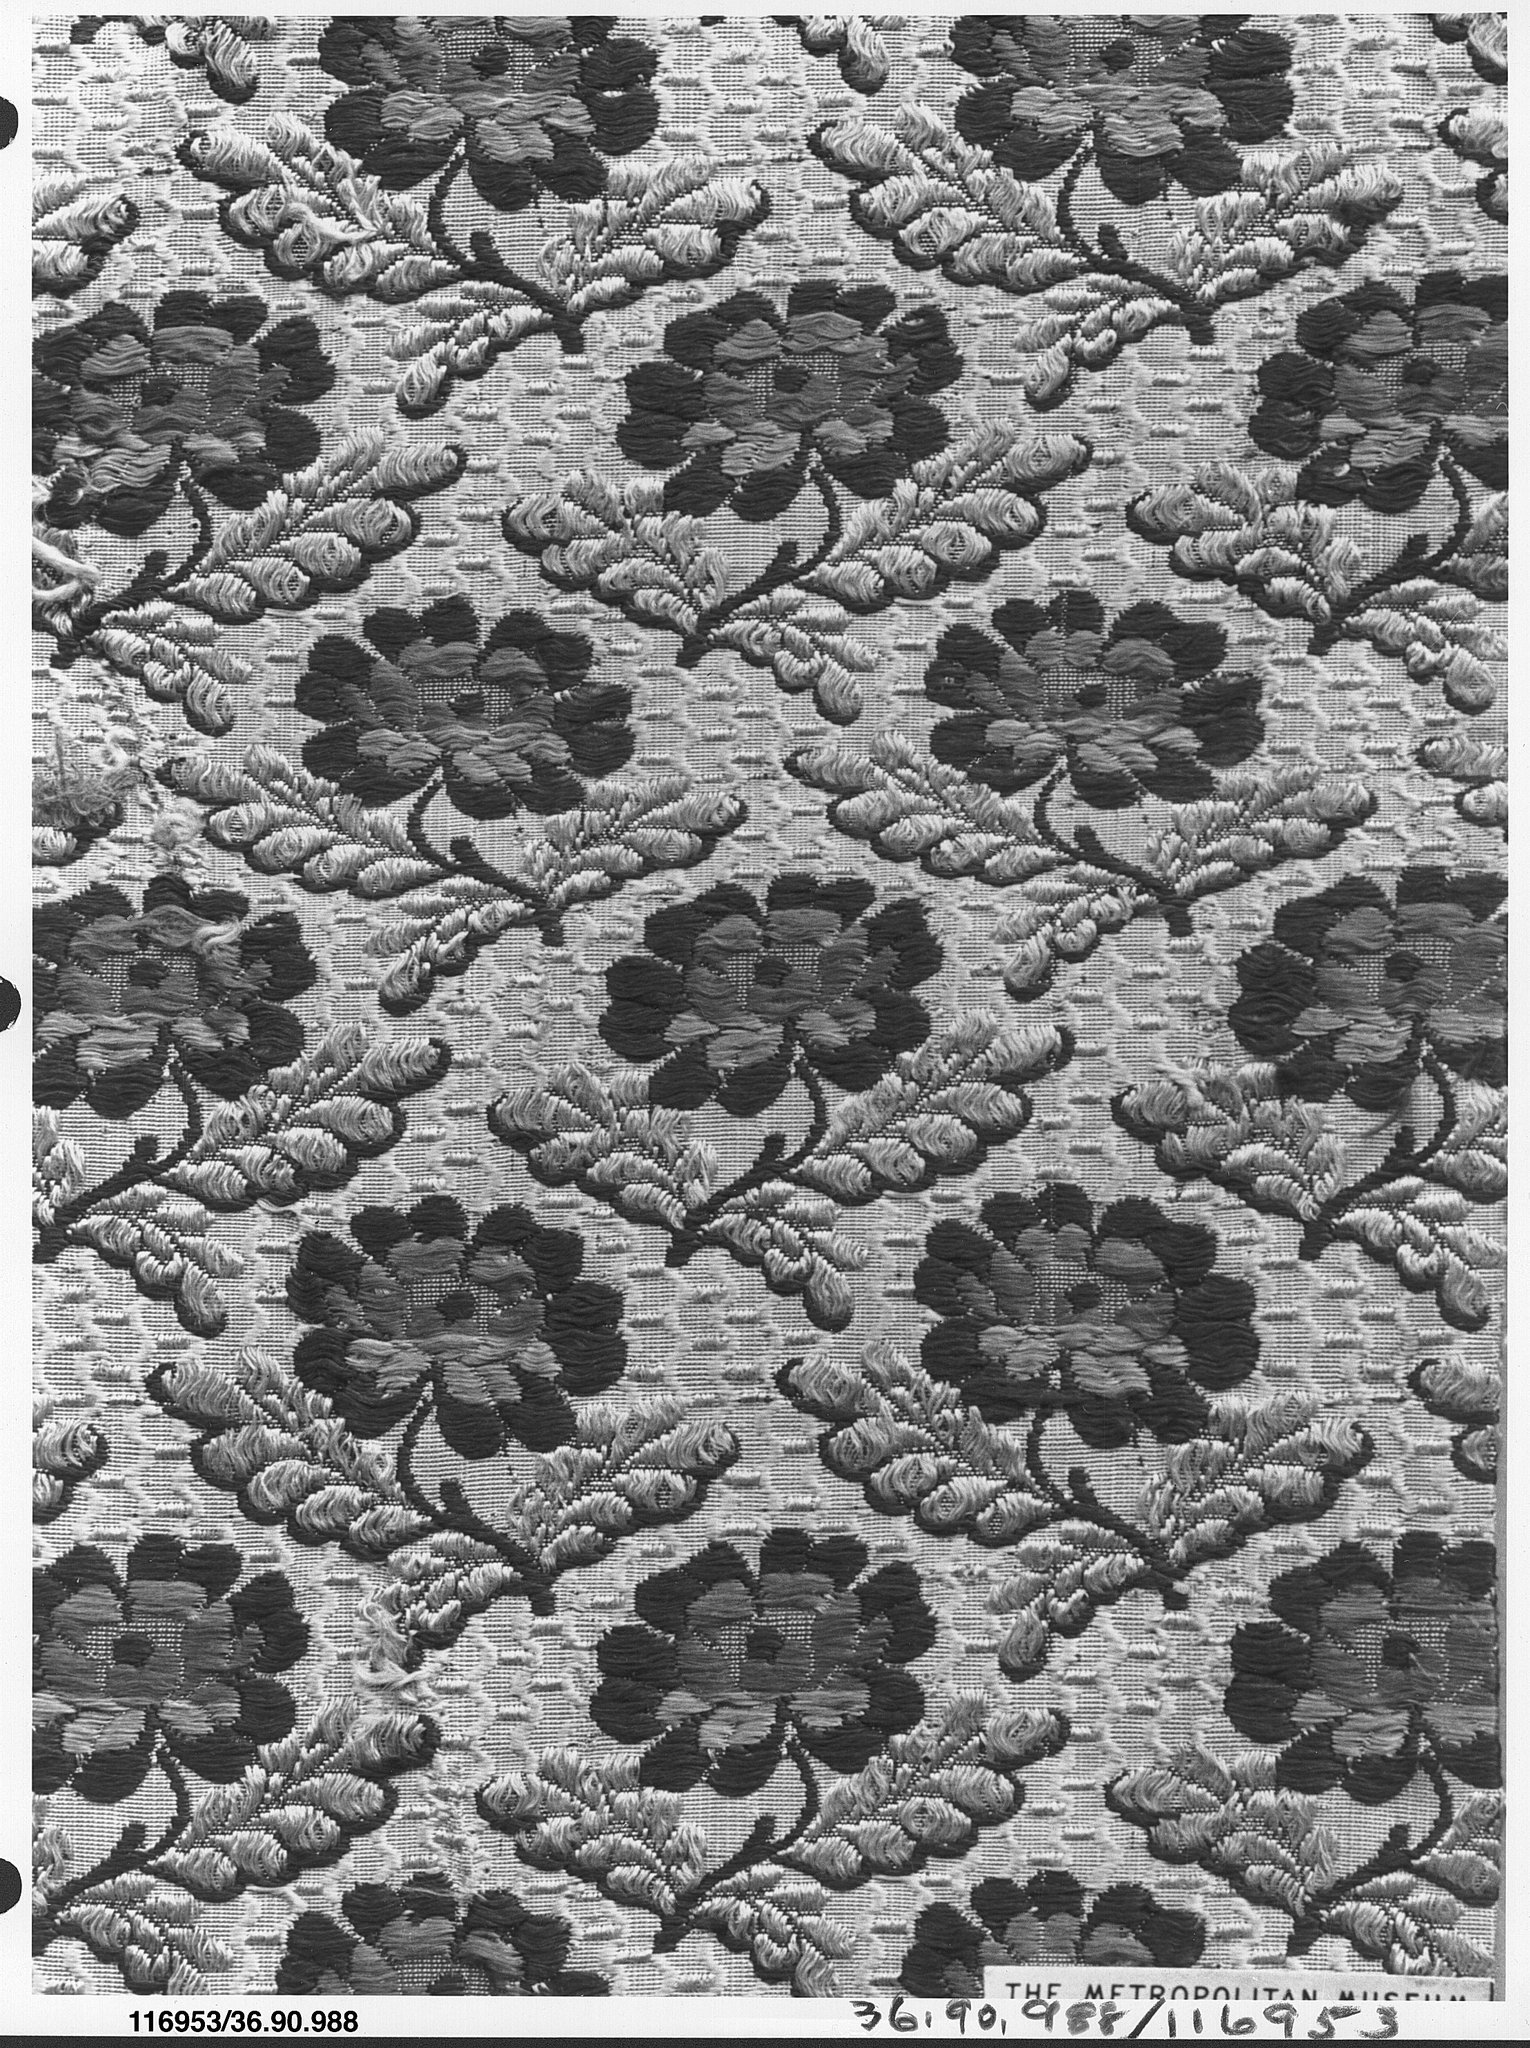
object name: piece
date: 1701-1800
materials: silk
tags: flowers,leaves